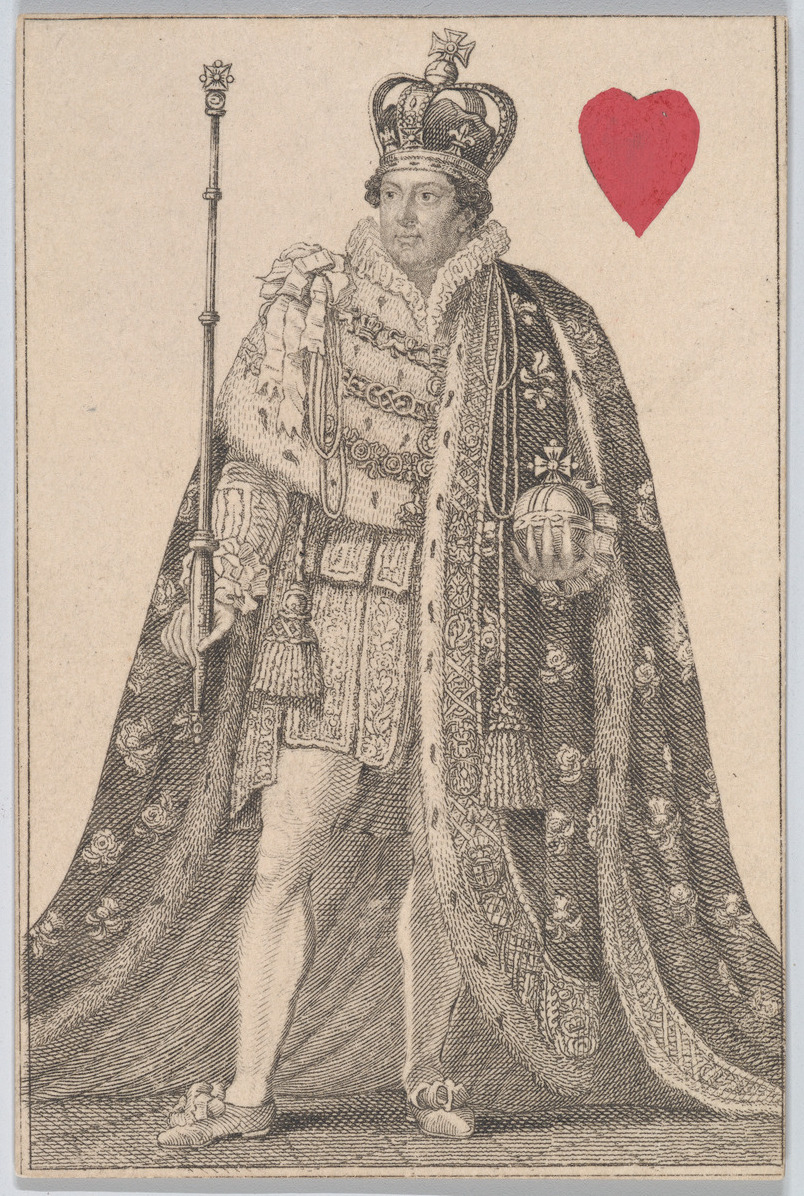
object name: print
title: King (Geo. 4th from England), from "Court Game of Geography"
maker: william and henry rock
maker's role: publisher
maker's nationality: british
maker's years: 1821-1884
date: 1838-1855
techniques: engraving, etching, hand coloring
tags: kings,playing cards